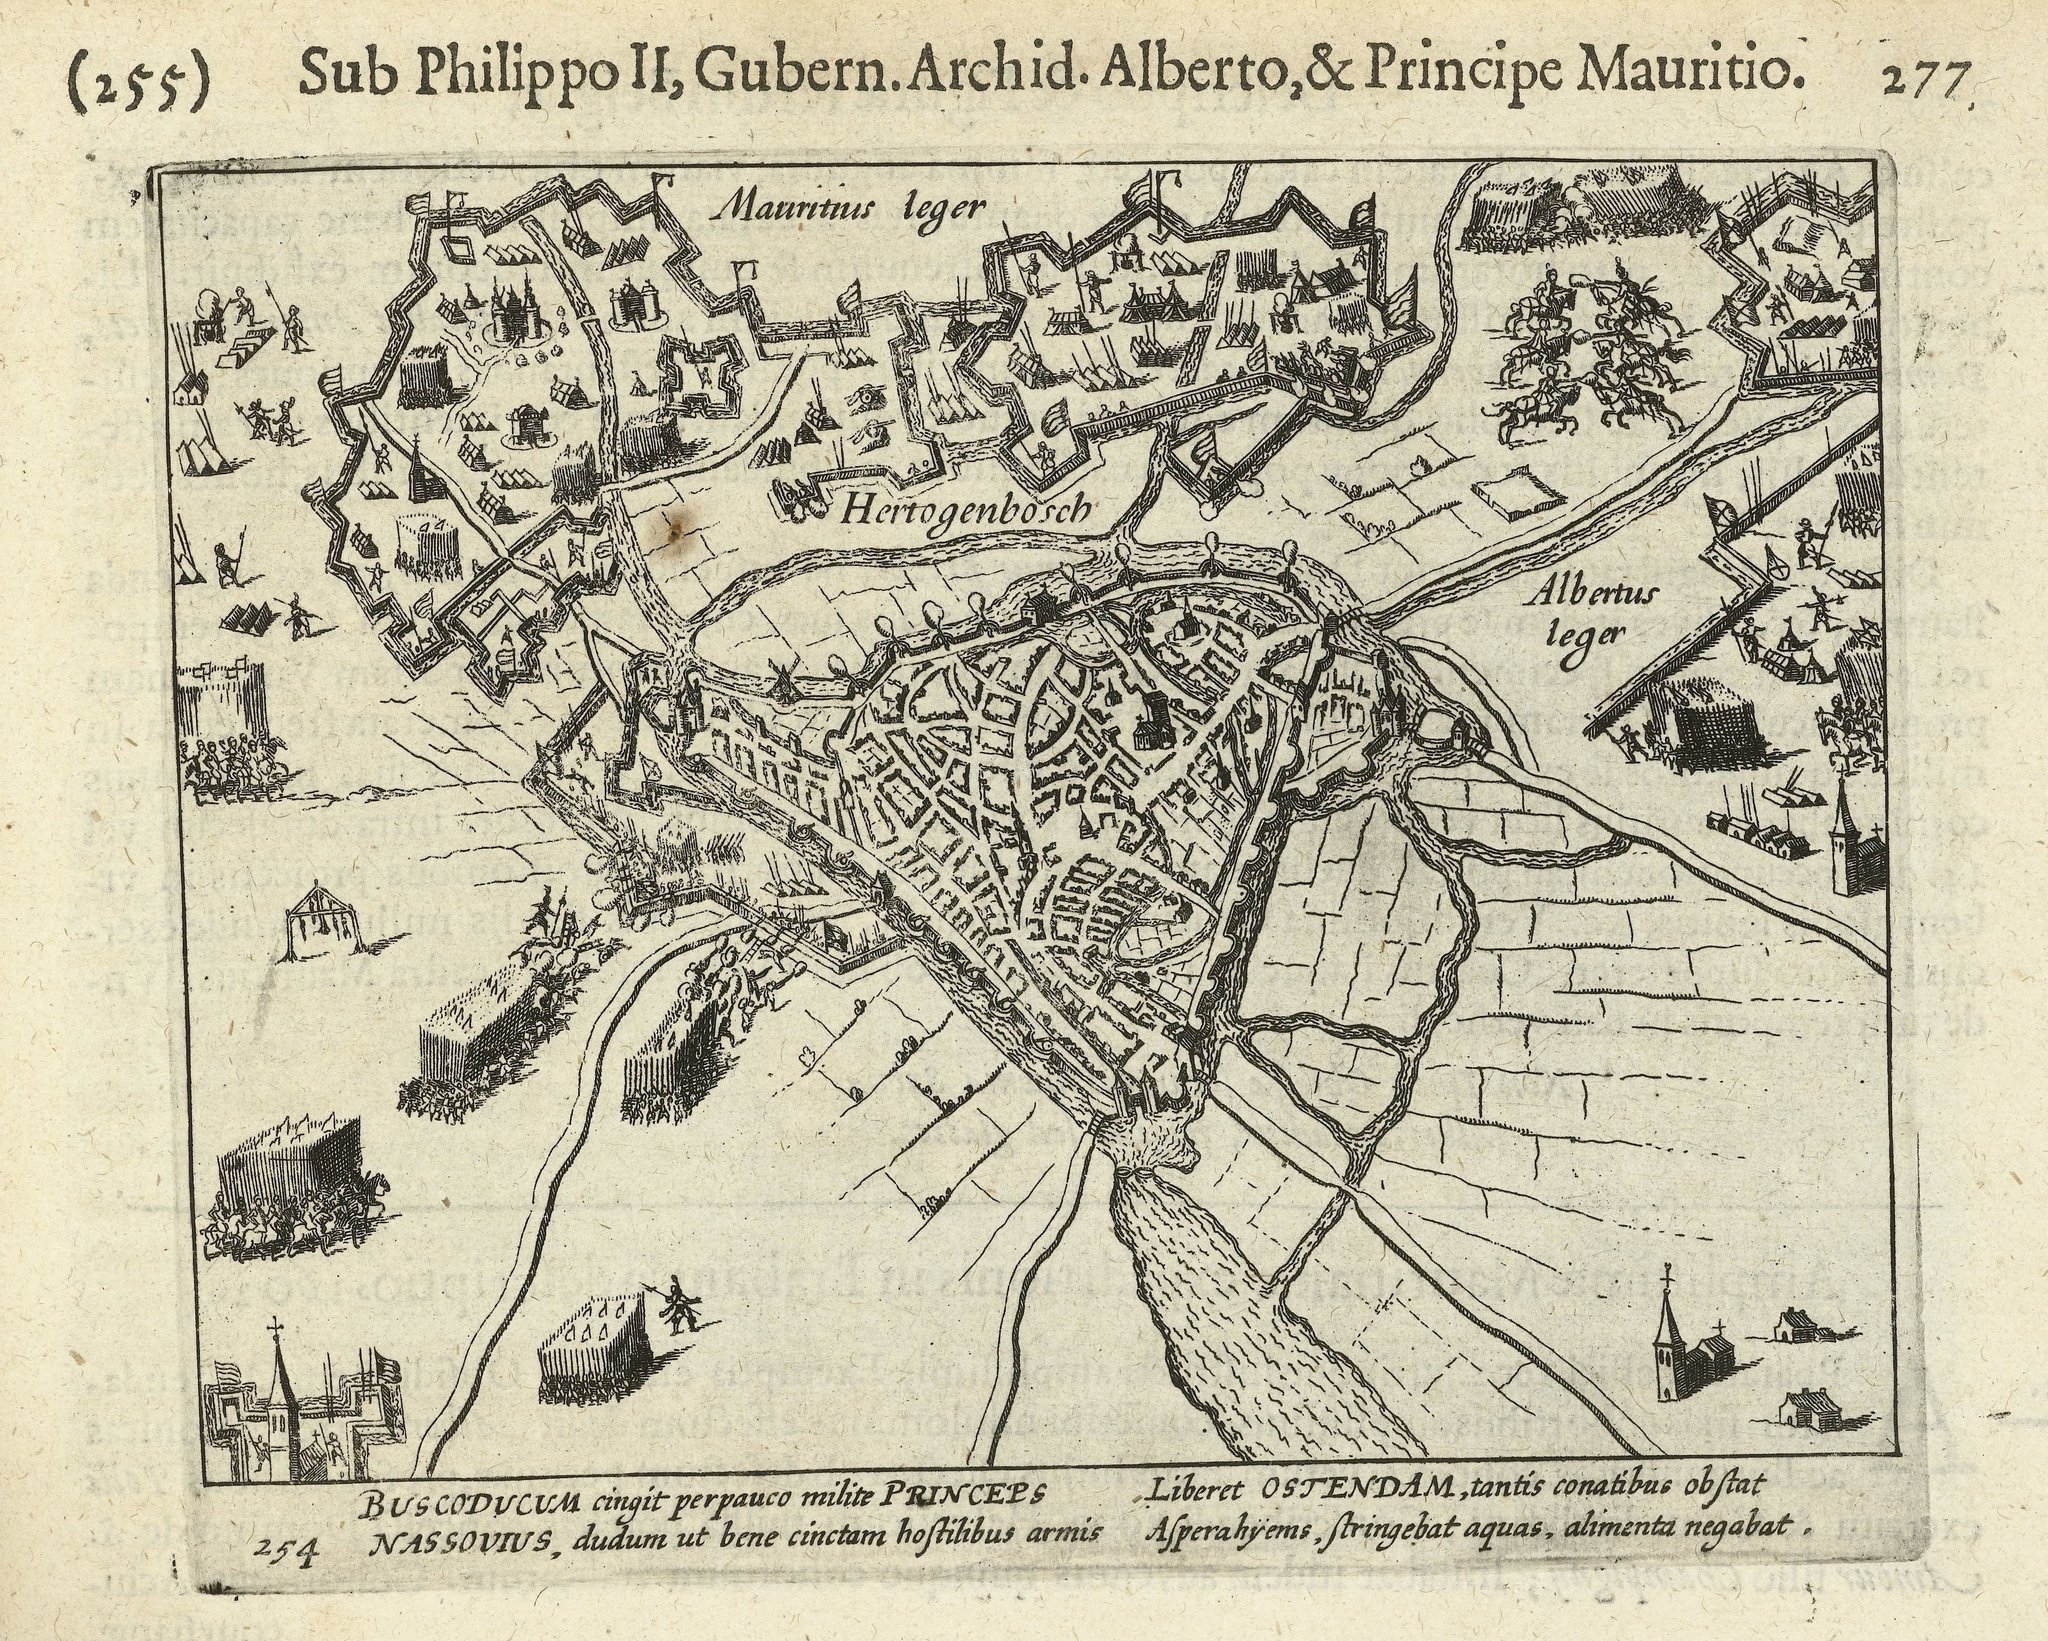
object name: history print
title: 's-Hertogenbosch belegerd door Maurits, 1601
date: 1613-1615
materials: paper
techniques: etching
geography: amsterdam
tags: maurice (prince of orange), brussels, albrecht aartshertog van oostenrijk, siege, position war, den bosch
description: 's-Hertogenbosch vruchteloos belegerd door Maurits, november 1601. Plan van de stad met omgeving en de ligging van de troepen van Maurits en Albrecht. Met onderschrift van 4 regels in het Latijn. Genummerd 254. Bedrukt op achterzijde met tekst in het Latijn.